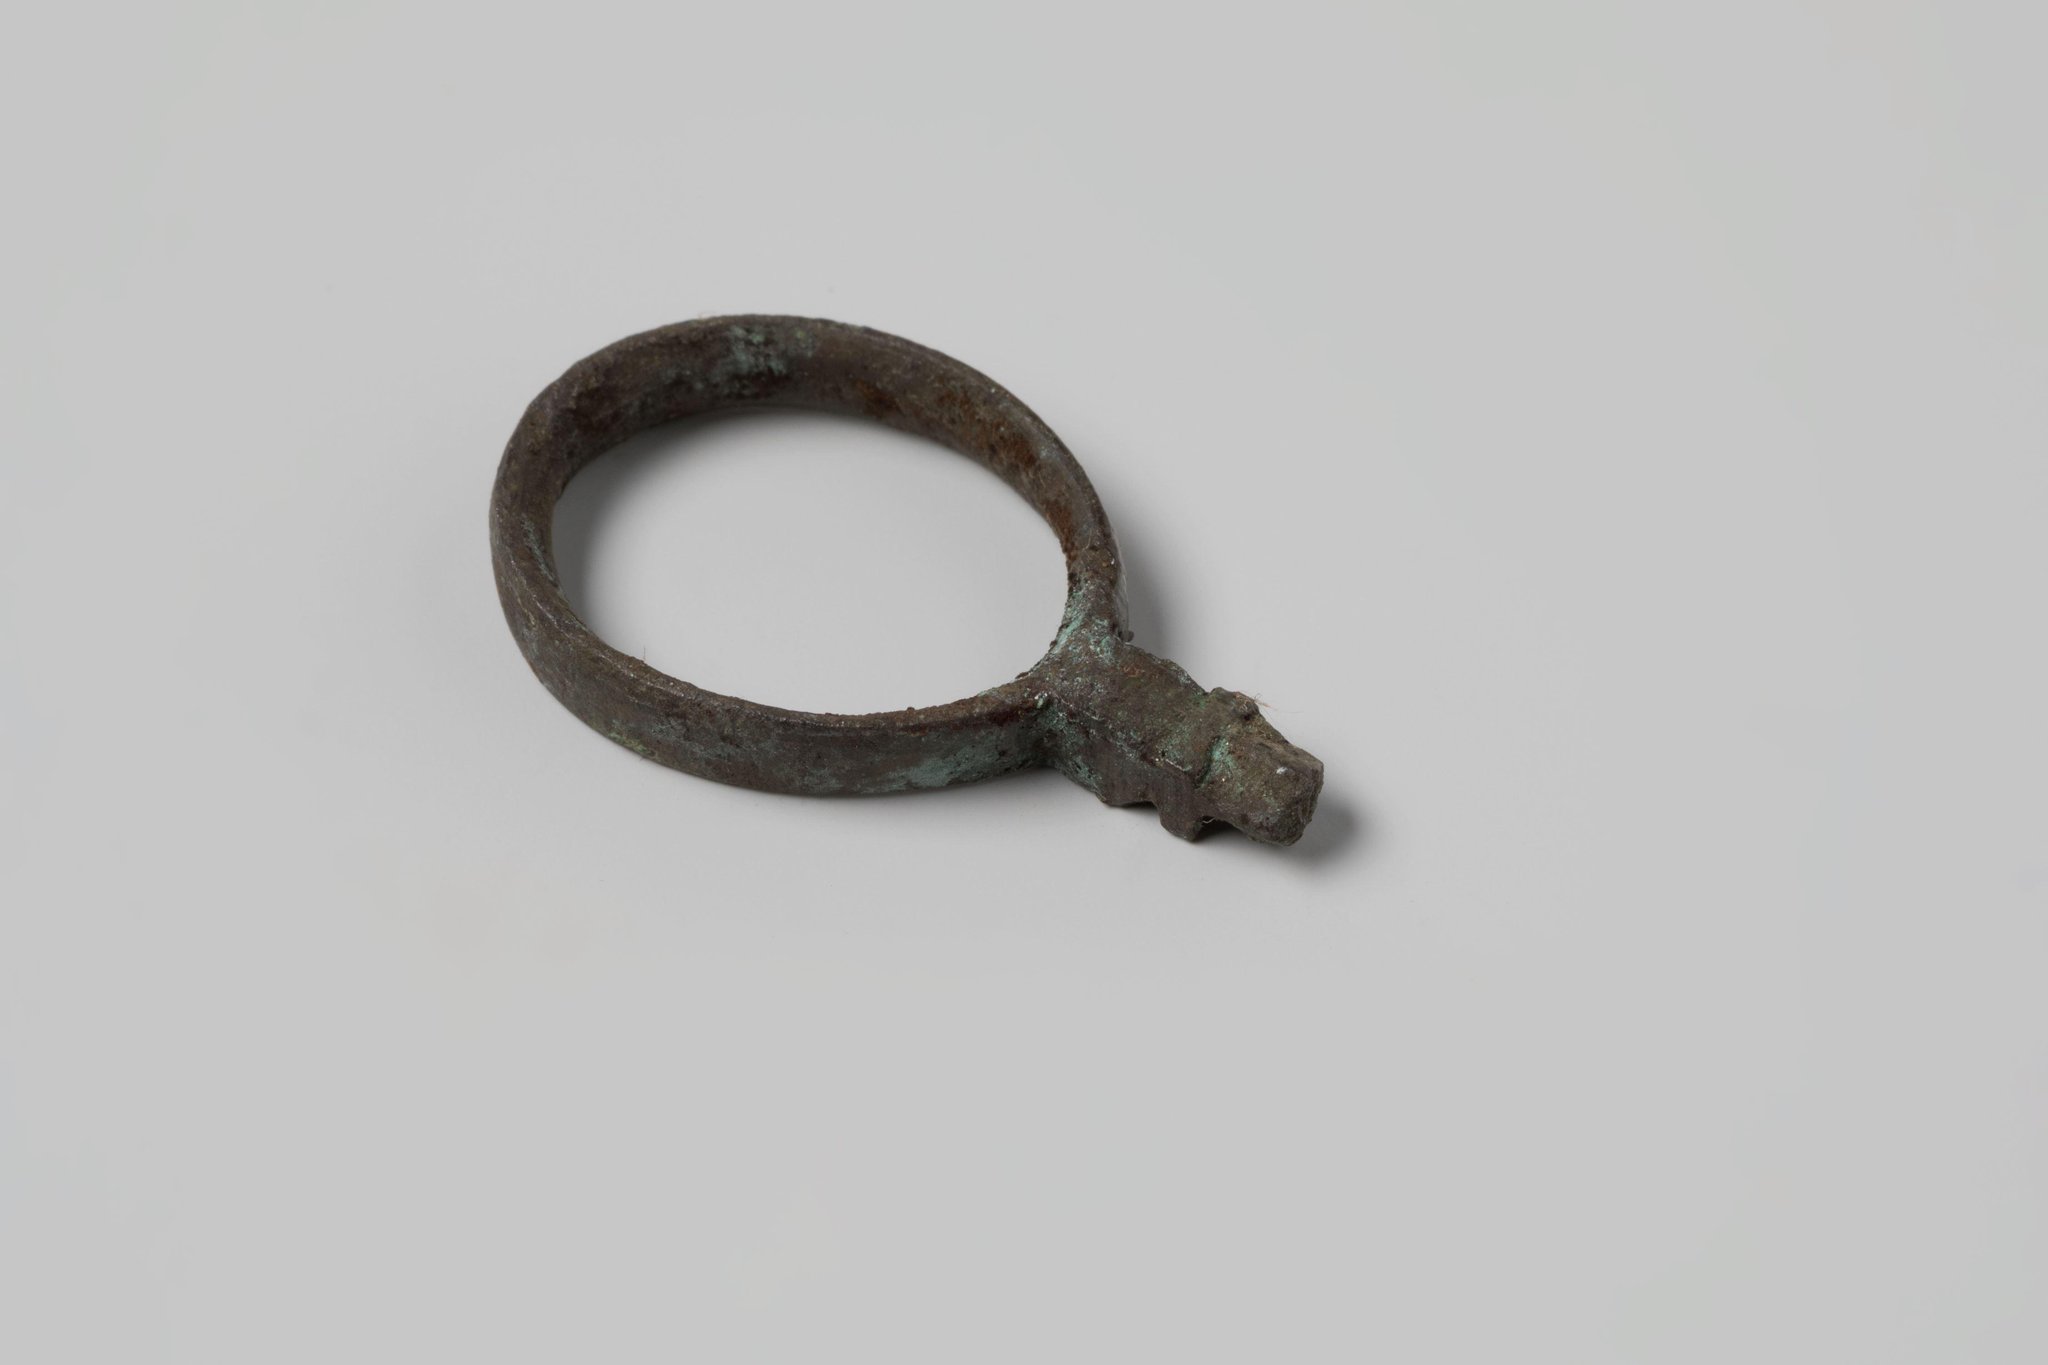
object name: pin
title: Speld uit het wrak van de Oost-Indiëvaarder Hollandia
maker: Anonymous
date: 1700-1743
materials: copper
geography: netherlands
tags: verenigde oostindische compagnie, hollandia (schip), annet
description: Tools and instruments, sewing and sailmaking, pin; fragm, bow, id. NG 1980-27H3265.